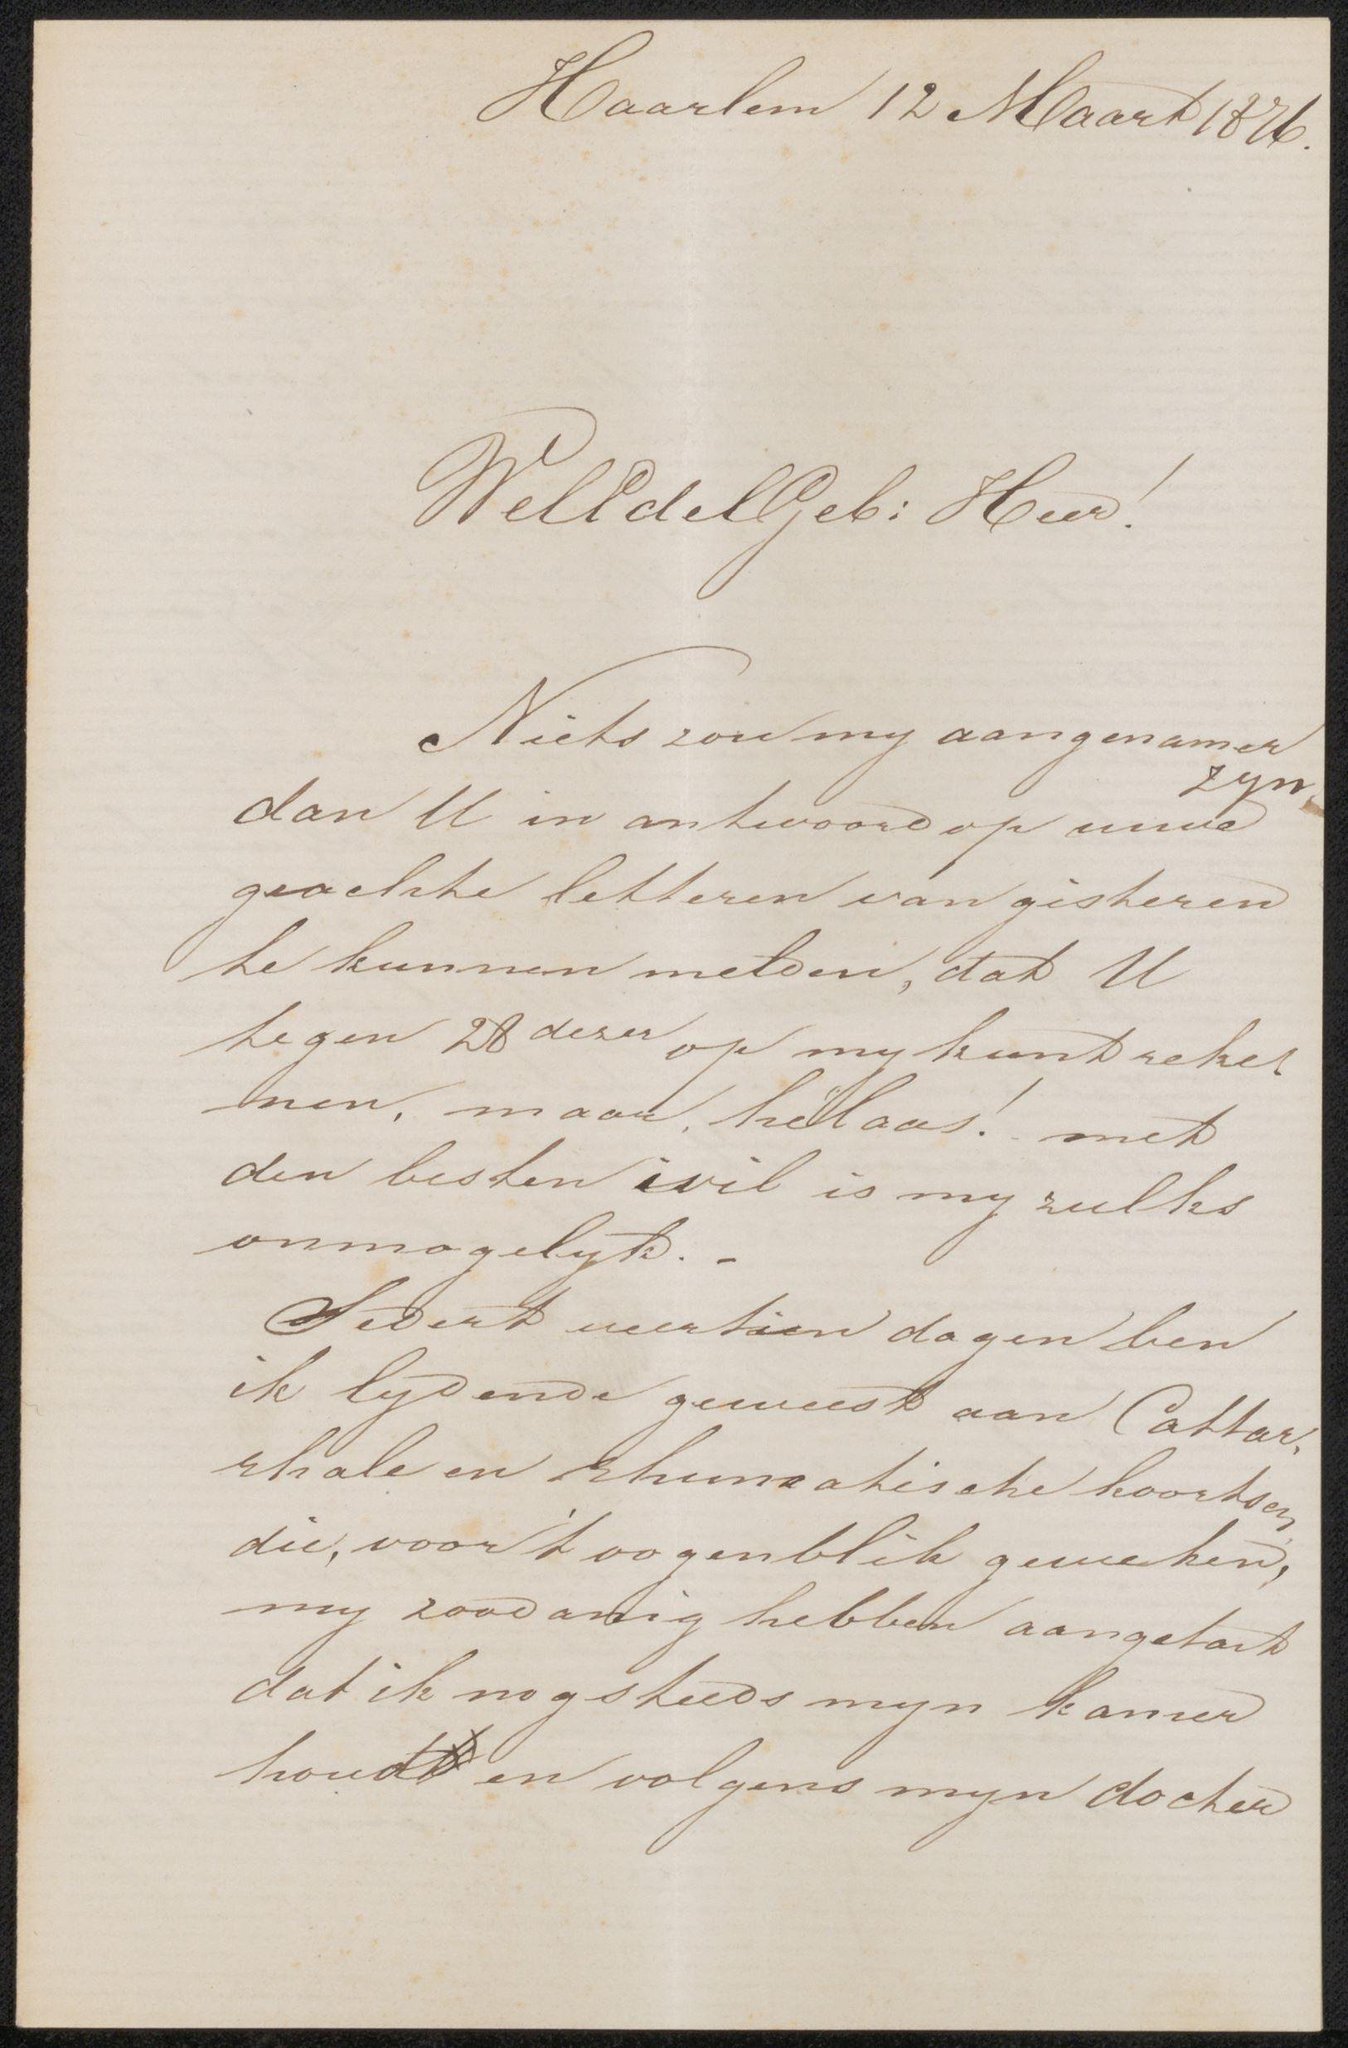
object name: letter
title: Brief aan anoniem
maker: hendrik jacobus scholten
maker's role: draughtsman, painter, print maker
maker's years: 1824-1907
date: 1876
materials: ink, paper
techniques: pen, writing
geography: haarlem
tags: diseases